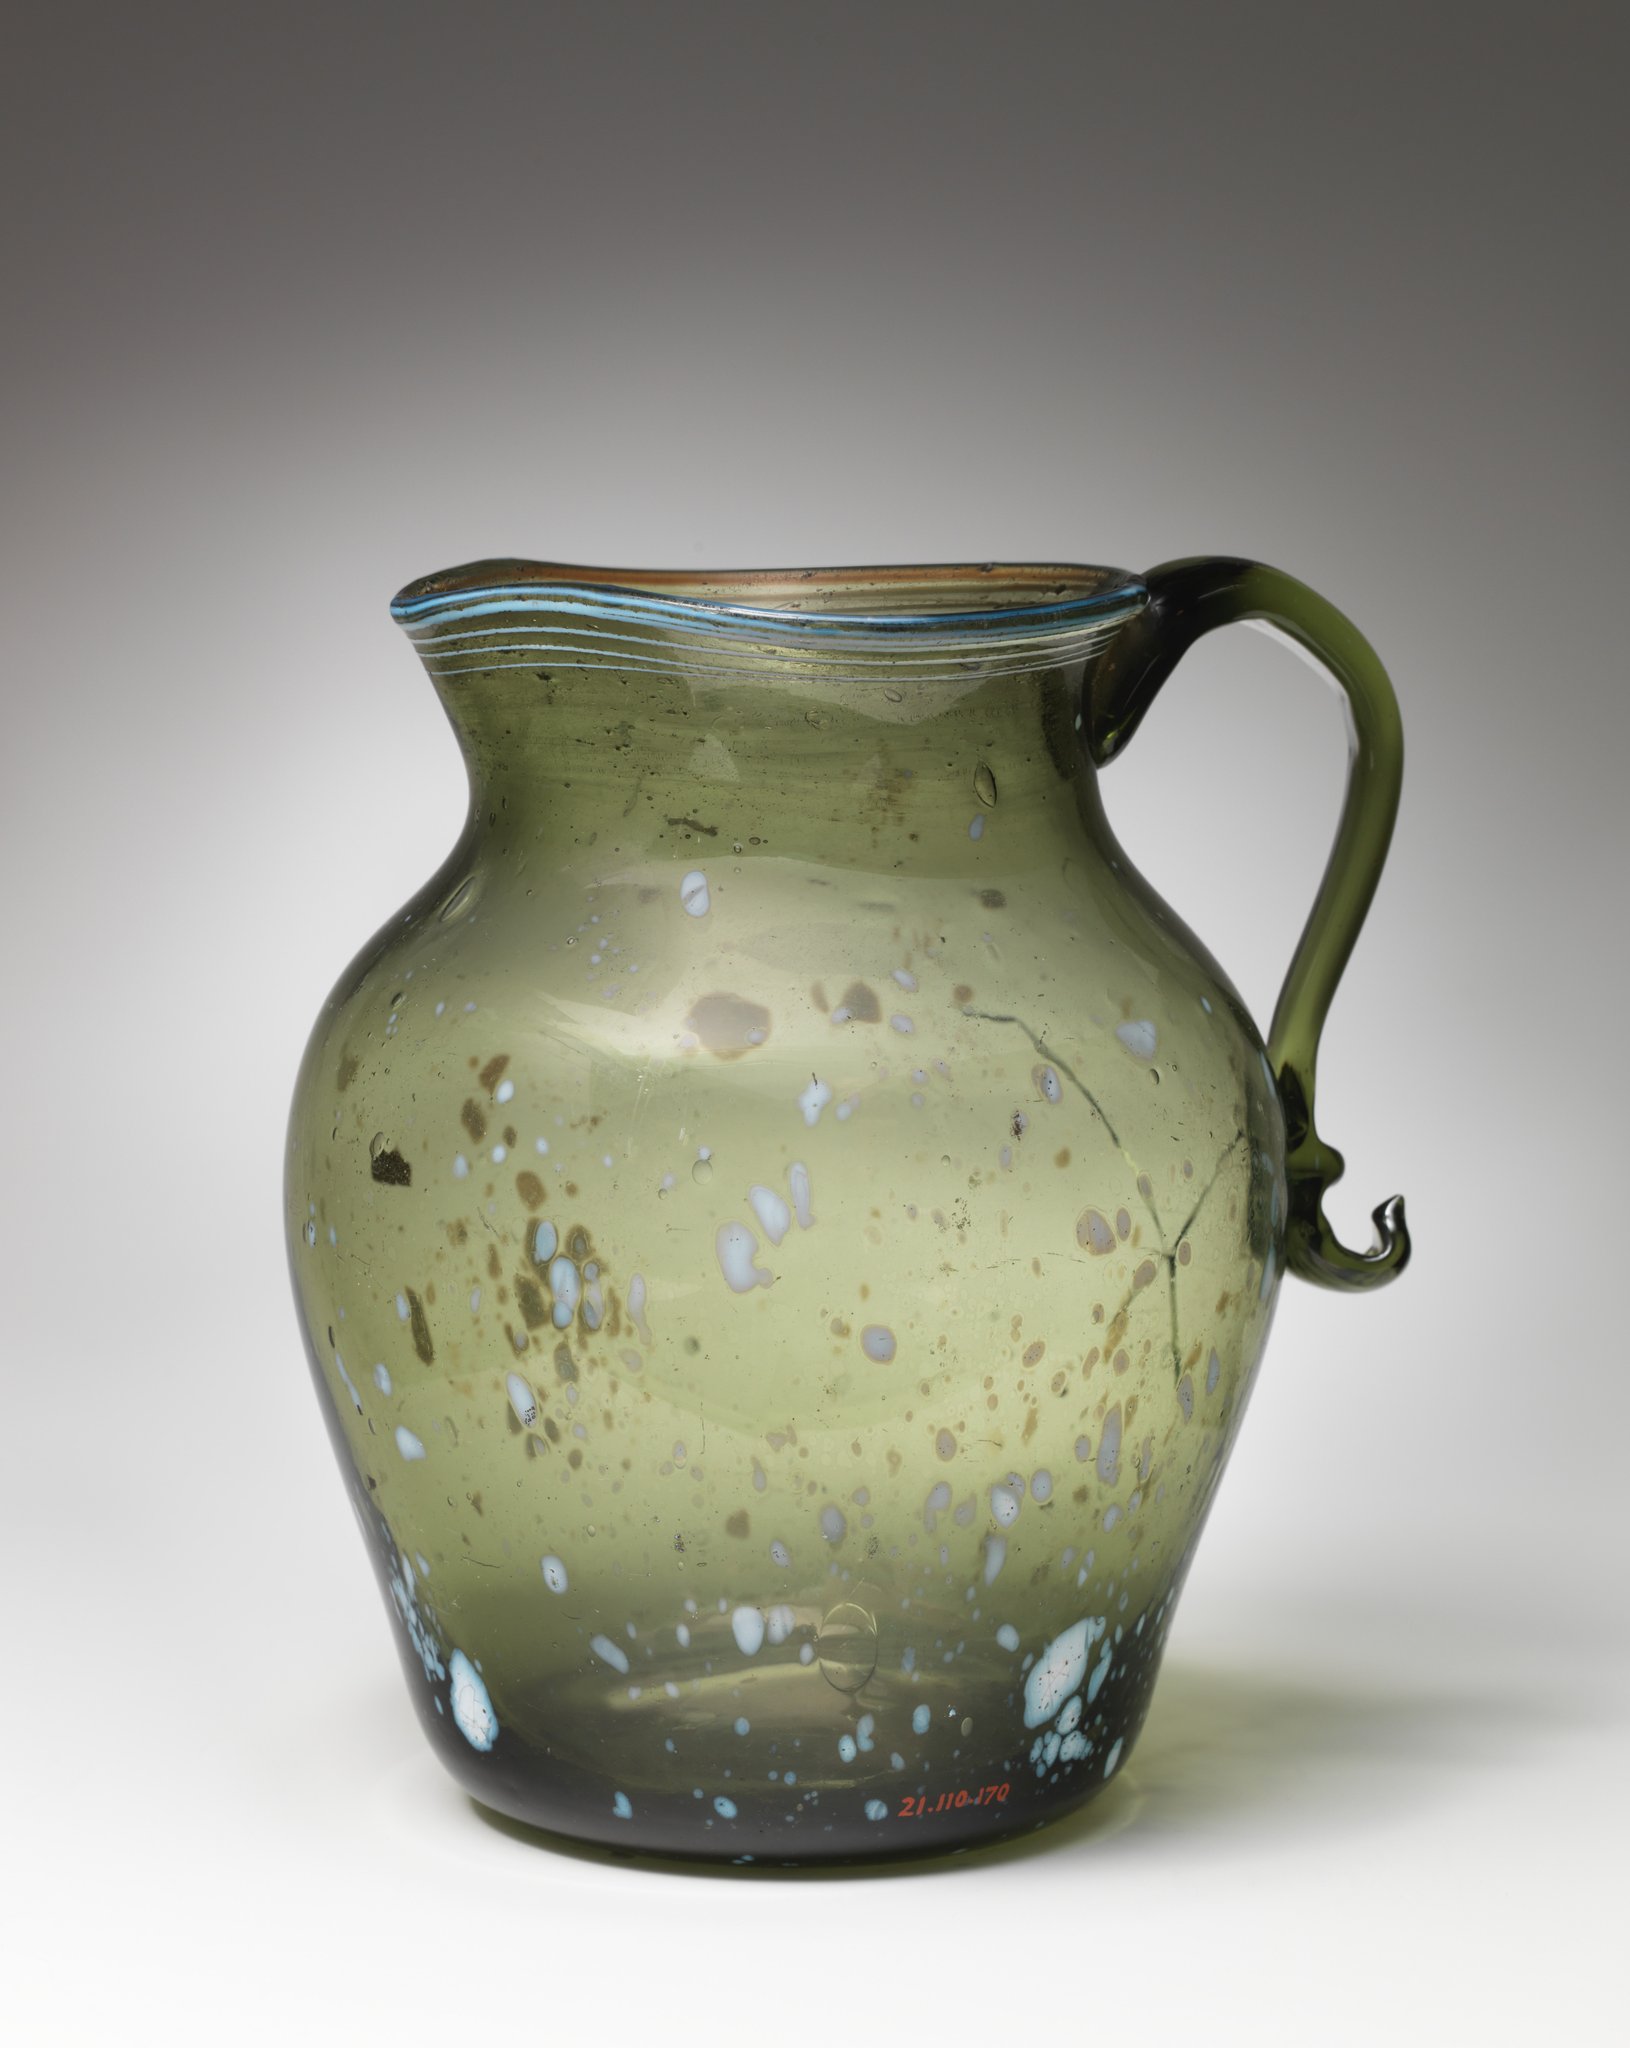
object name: jug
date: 1767-1833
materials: glass